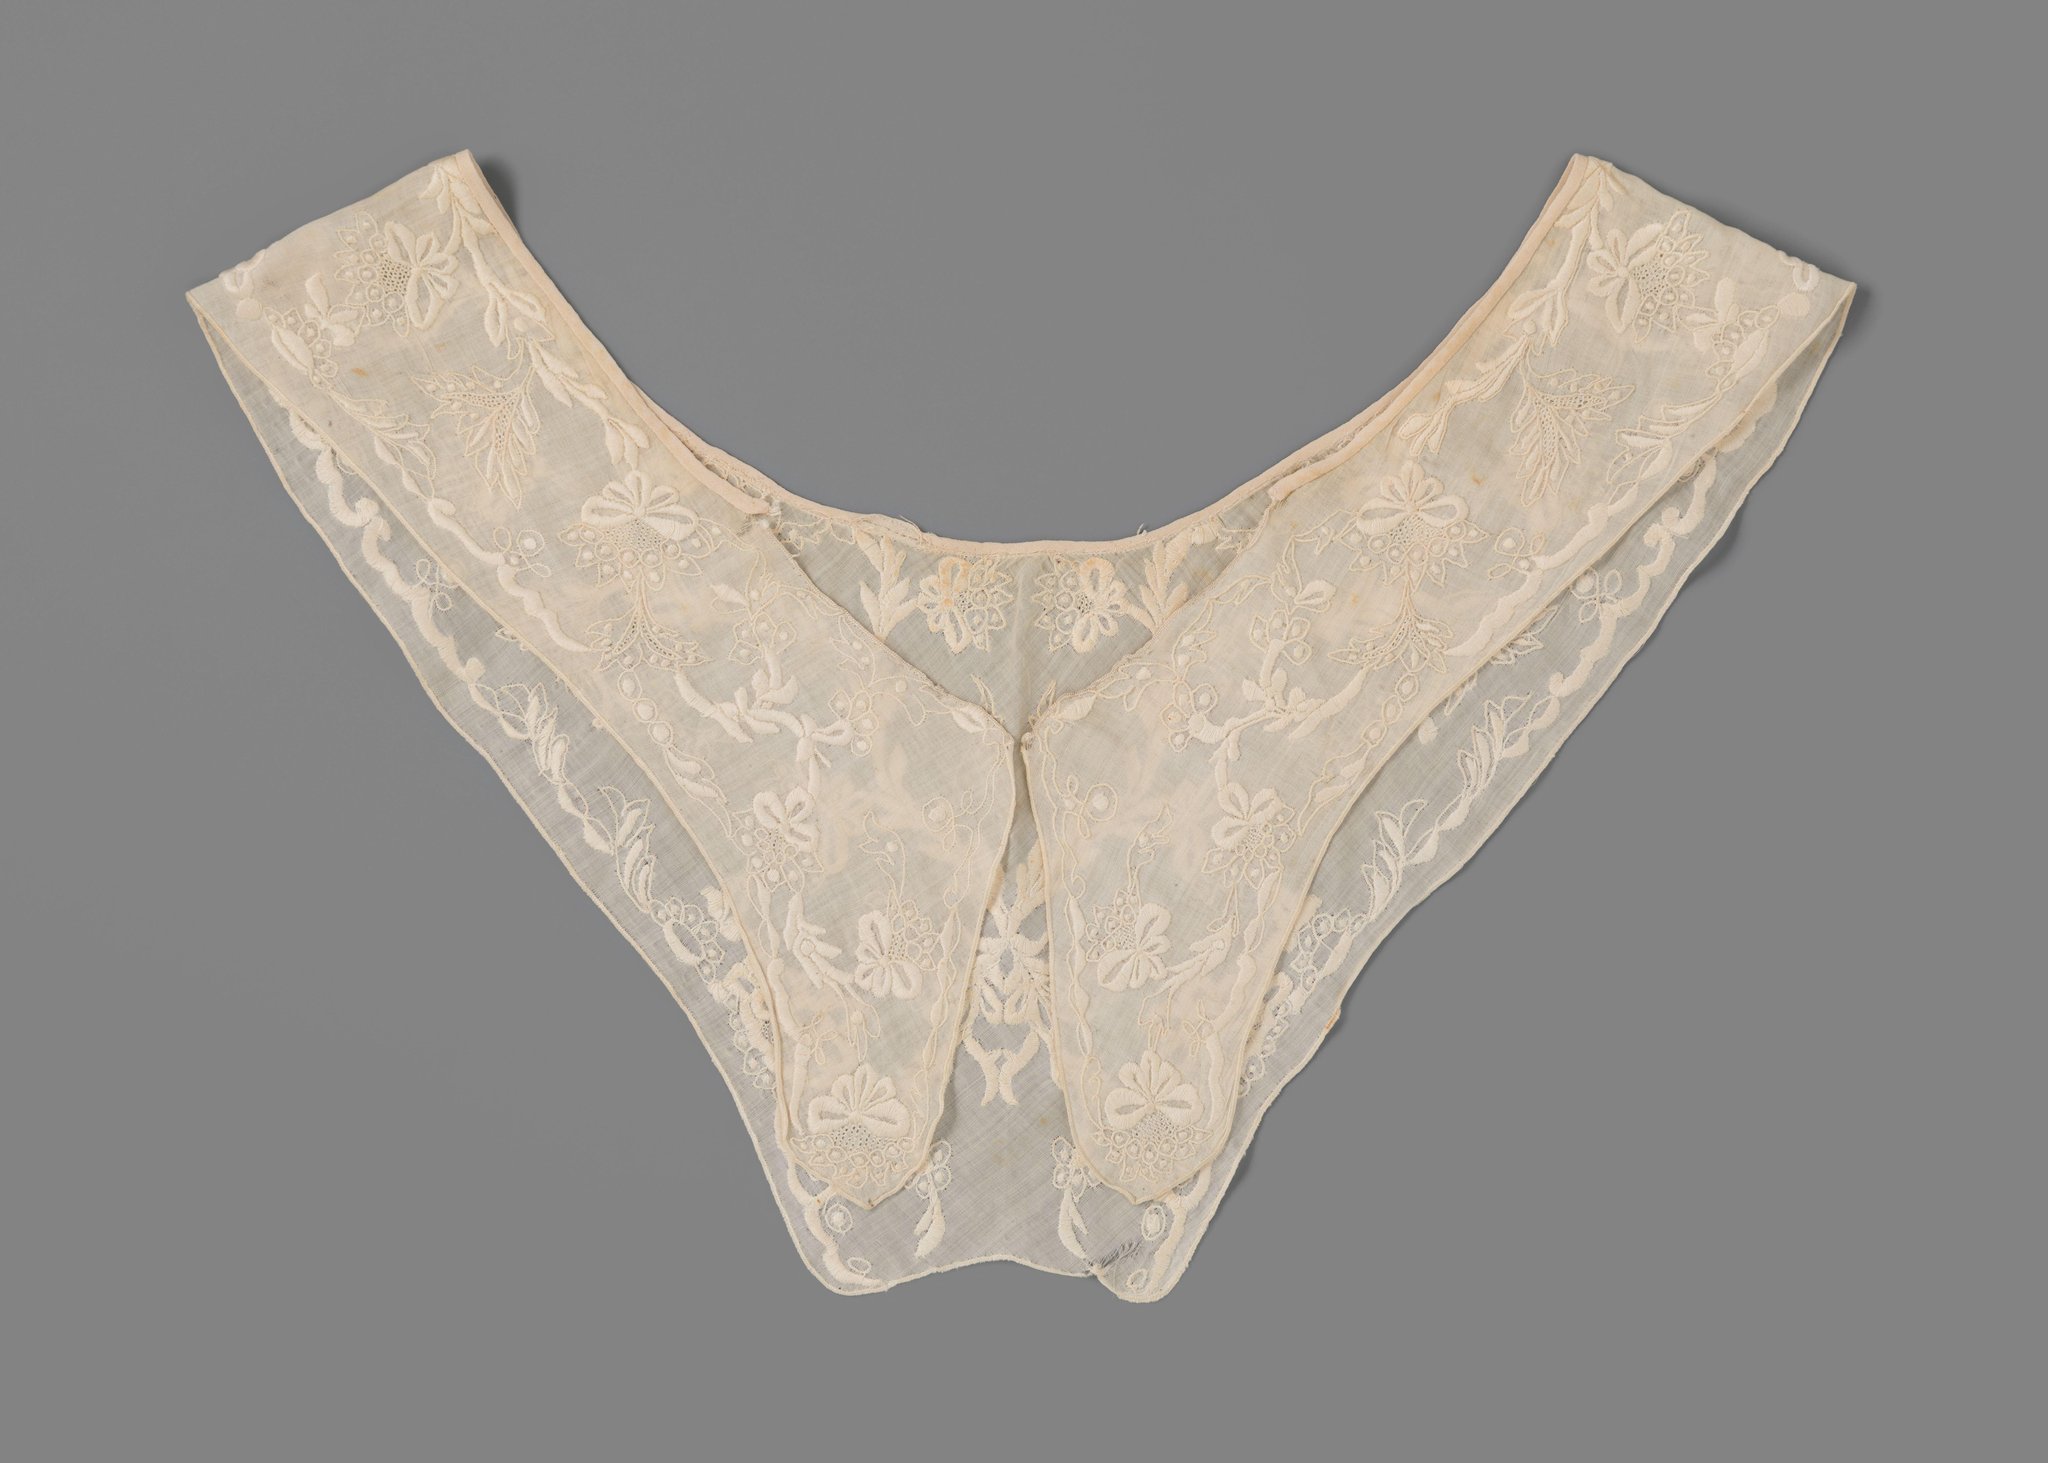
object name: collar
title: Kraag van batist met wit borduurwerk met lange uiteinden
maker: Anonymous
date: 1900-1940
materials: linen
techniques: embroidery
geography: western europe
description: Kraag van batist met wit borduurwerk met lange uiteinden. De rand is gefestonneerd en het schaduwwerk bestaat uit bladertakken met exotische bloemen. Enkele delen zijn opengewerkt.